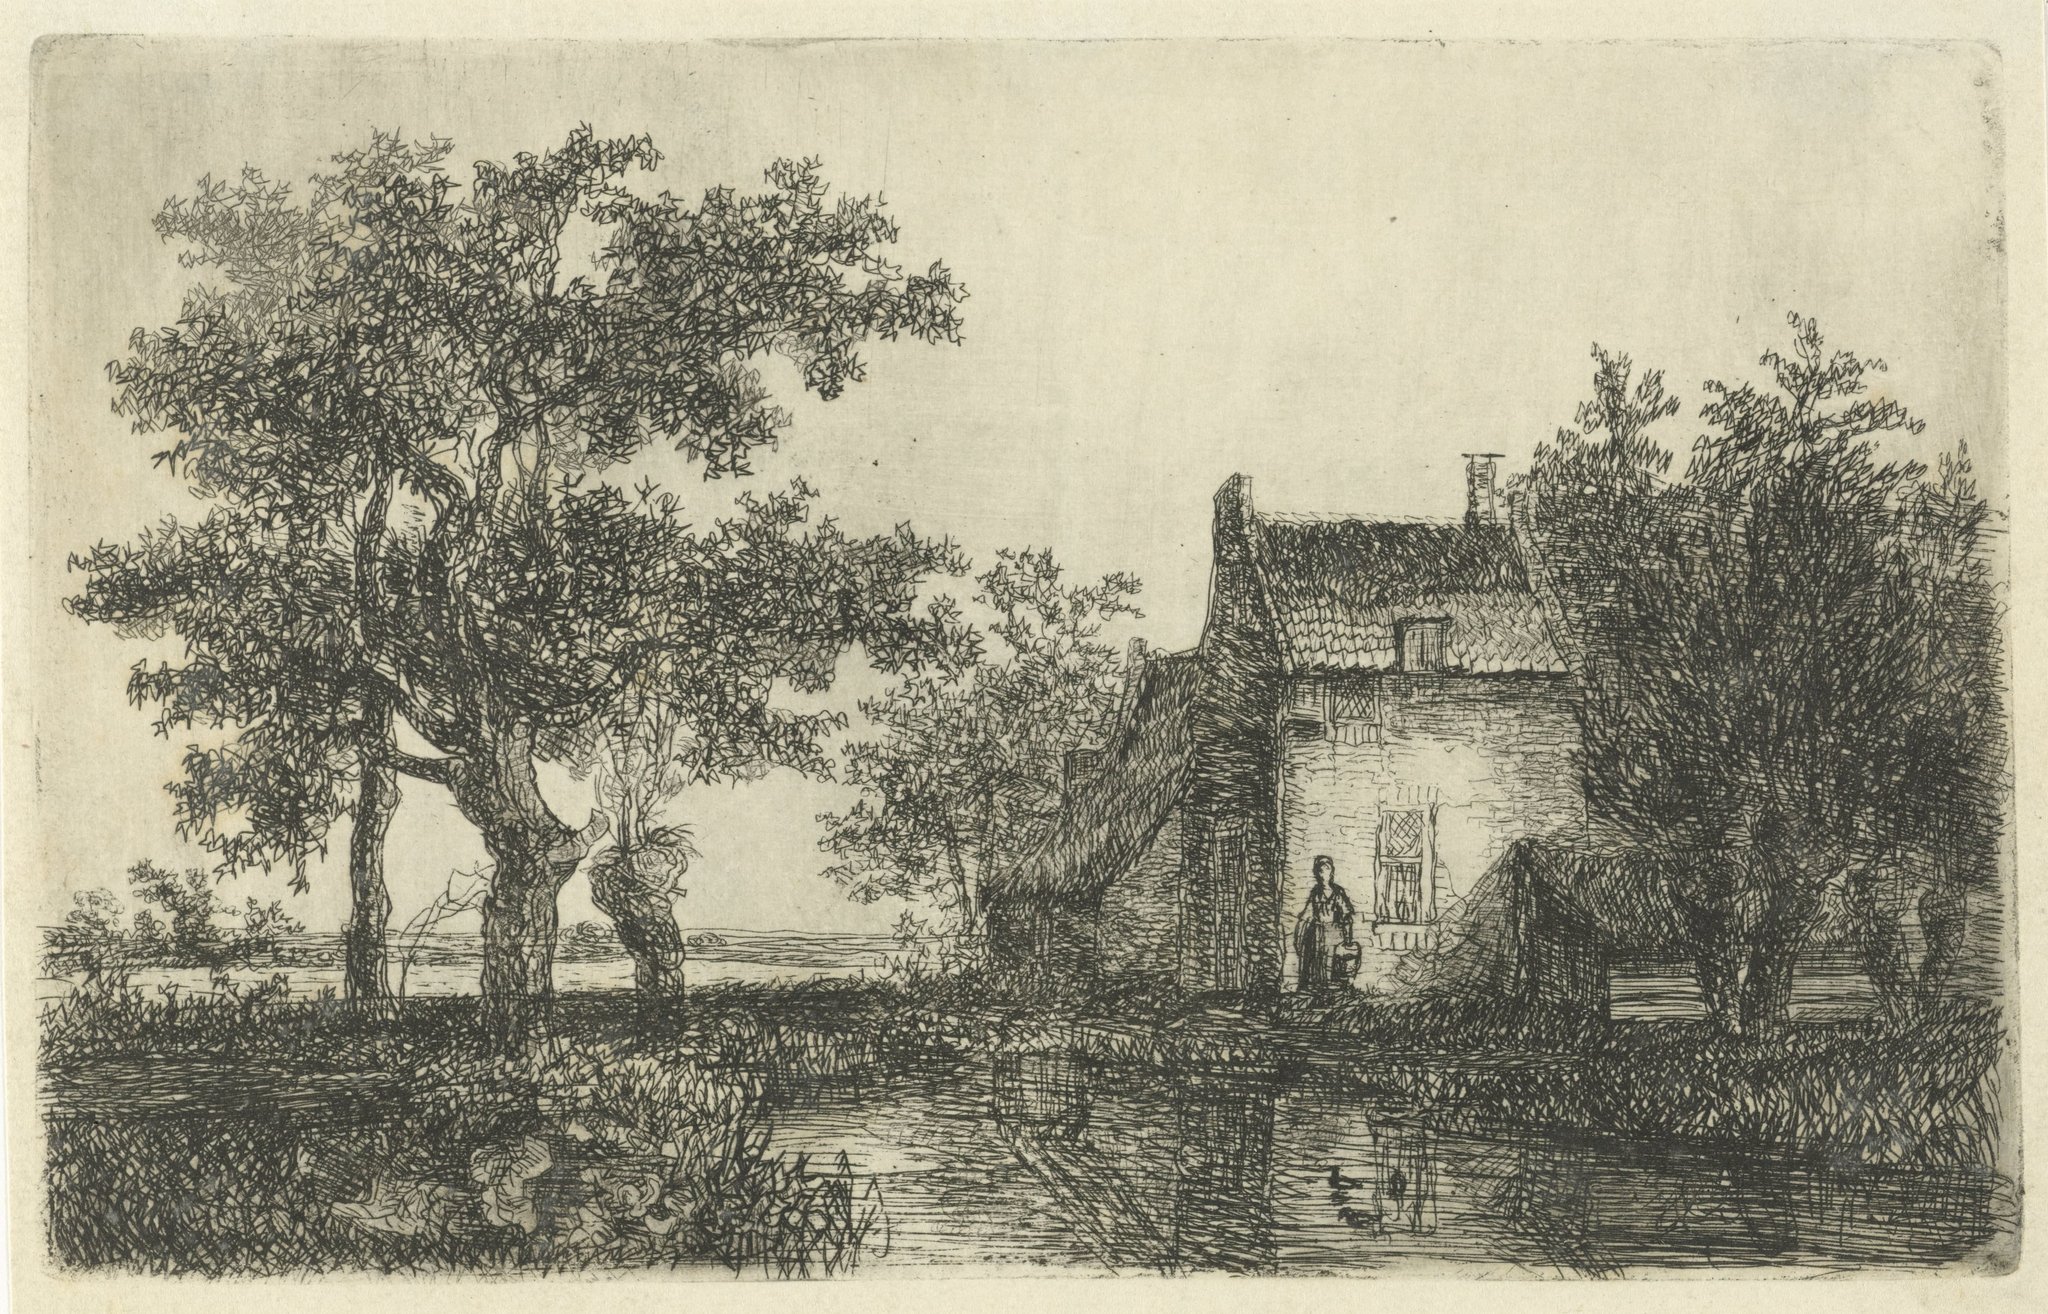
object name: print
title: Vrouw met een mand voor een boerenhuis aan het water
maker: hermanus jan hendrik van rijkelijkhuysen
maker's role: painter, print maker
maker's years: 1813-1883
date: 1857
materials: paper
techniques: drypoint, etching, intaglio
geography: utrecht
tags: trees, small canal, ditch, farm or solitary house in landscape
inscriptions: collector's mark: Lugt 2228, collector's mark: Lugt 1485